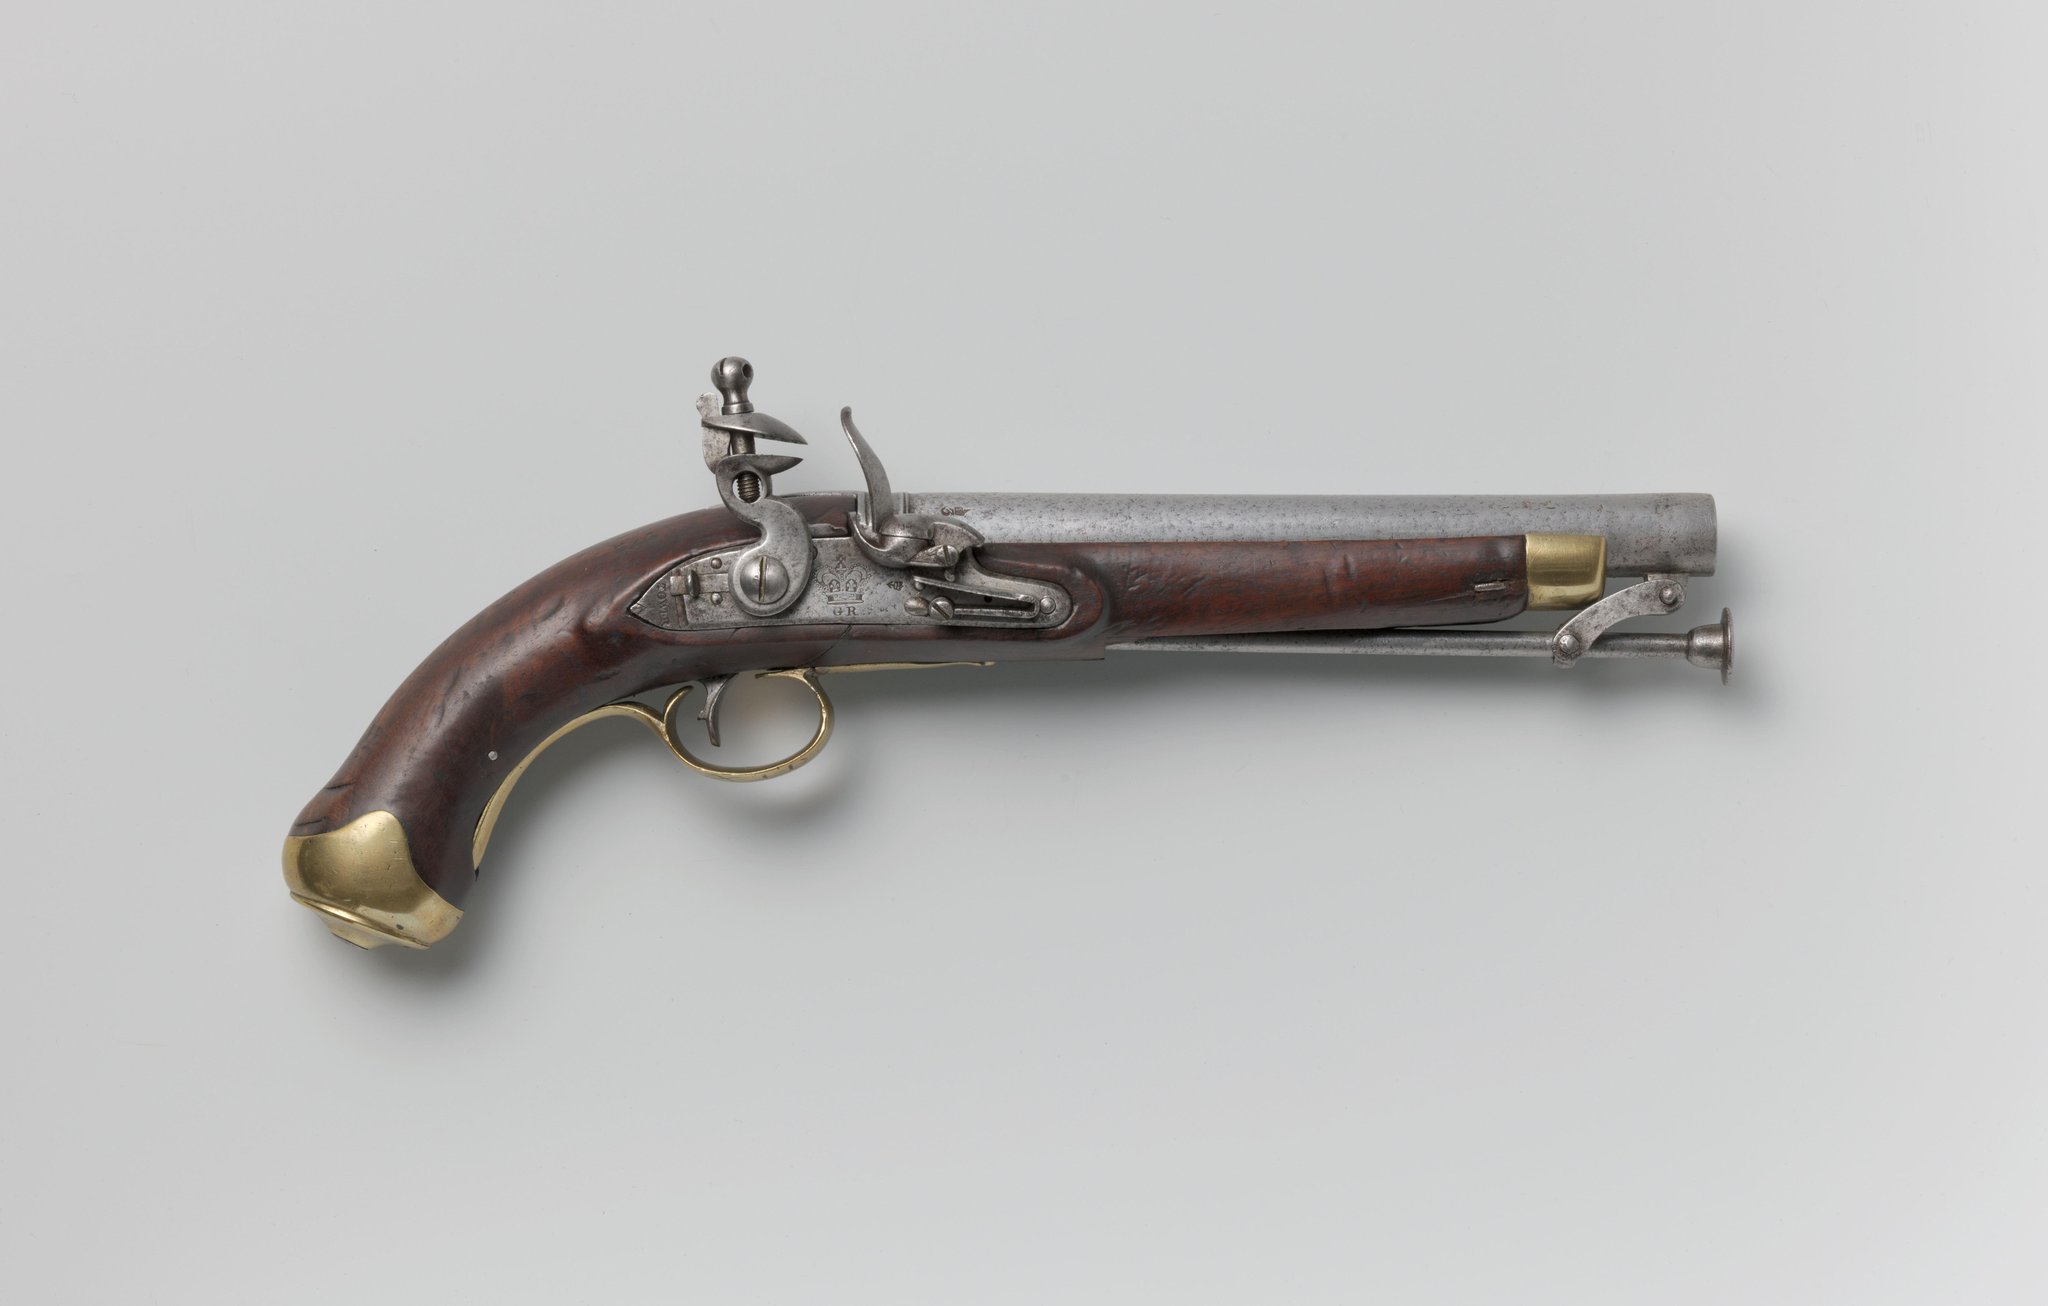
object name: flintlock pistol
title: Vuursteenpistool van het slagveld van Waterloo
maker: Anonymous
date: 1800-1815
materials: copper, steel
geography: great britain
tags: waterloo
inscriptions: mark: ‘GR’, mark: ‘GR’, mark: ‘X I-D / A // 26’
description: Vuursteenpistool, behorend tot koppel, met een stalen gladde, ronde loop en plat stalen slot (gemerkt). Onder, aan voorzijde loop, beweegbare beugel met stalen vaste laadstok, welke in deels verdwenen wortelnoten houten lade is gezet. Achterzijde van de loop heeft een ring en staart met schroef. Voorzijde lade met koperen ladeband. Koperen schroefplaat met twee stalen bouten. Koperen trekkerbeugel (gemerkt). Koperen kofkap met stalen schroef. Het pistool is meegebracht van het slagveld van Waterloo door J.J. Nepveu, 2e luitenant bij het 6e Regiment Huzaren.